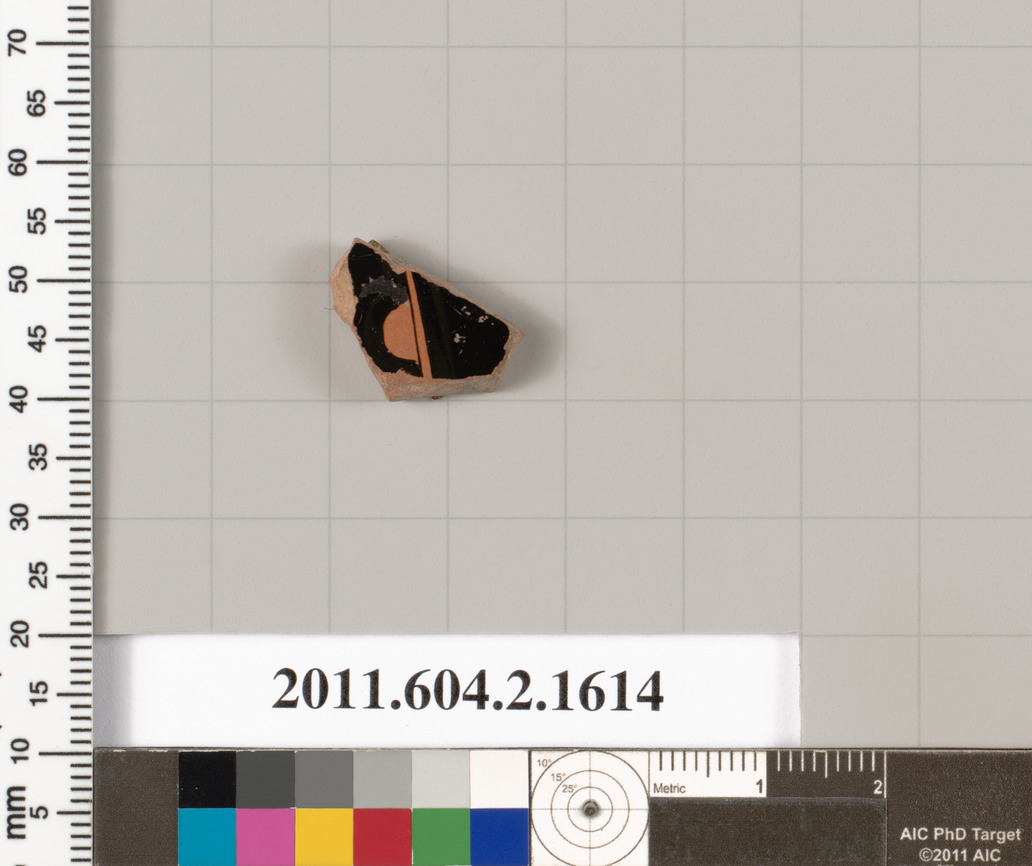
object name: skyphos fragment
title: Terracotta fragment of a skyphos (deep drinking cup)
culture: greek, attic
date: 475-451 BCE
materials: terracotta